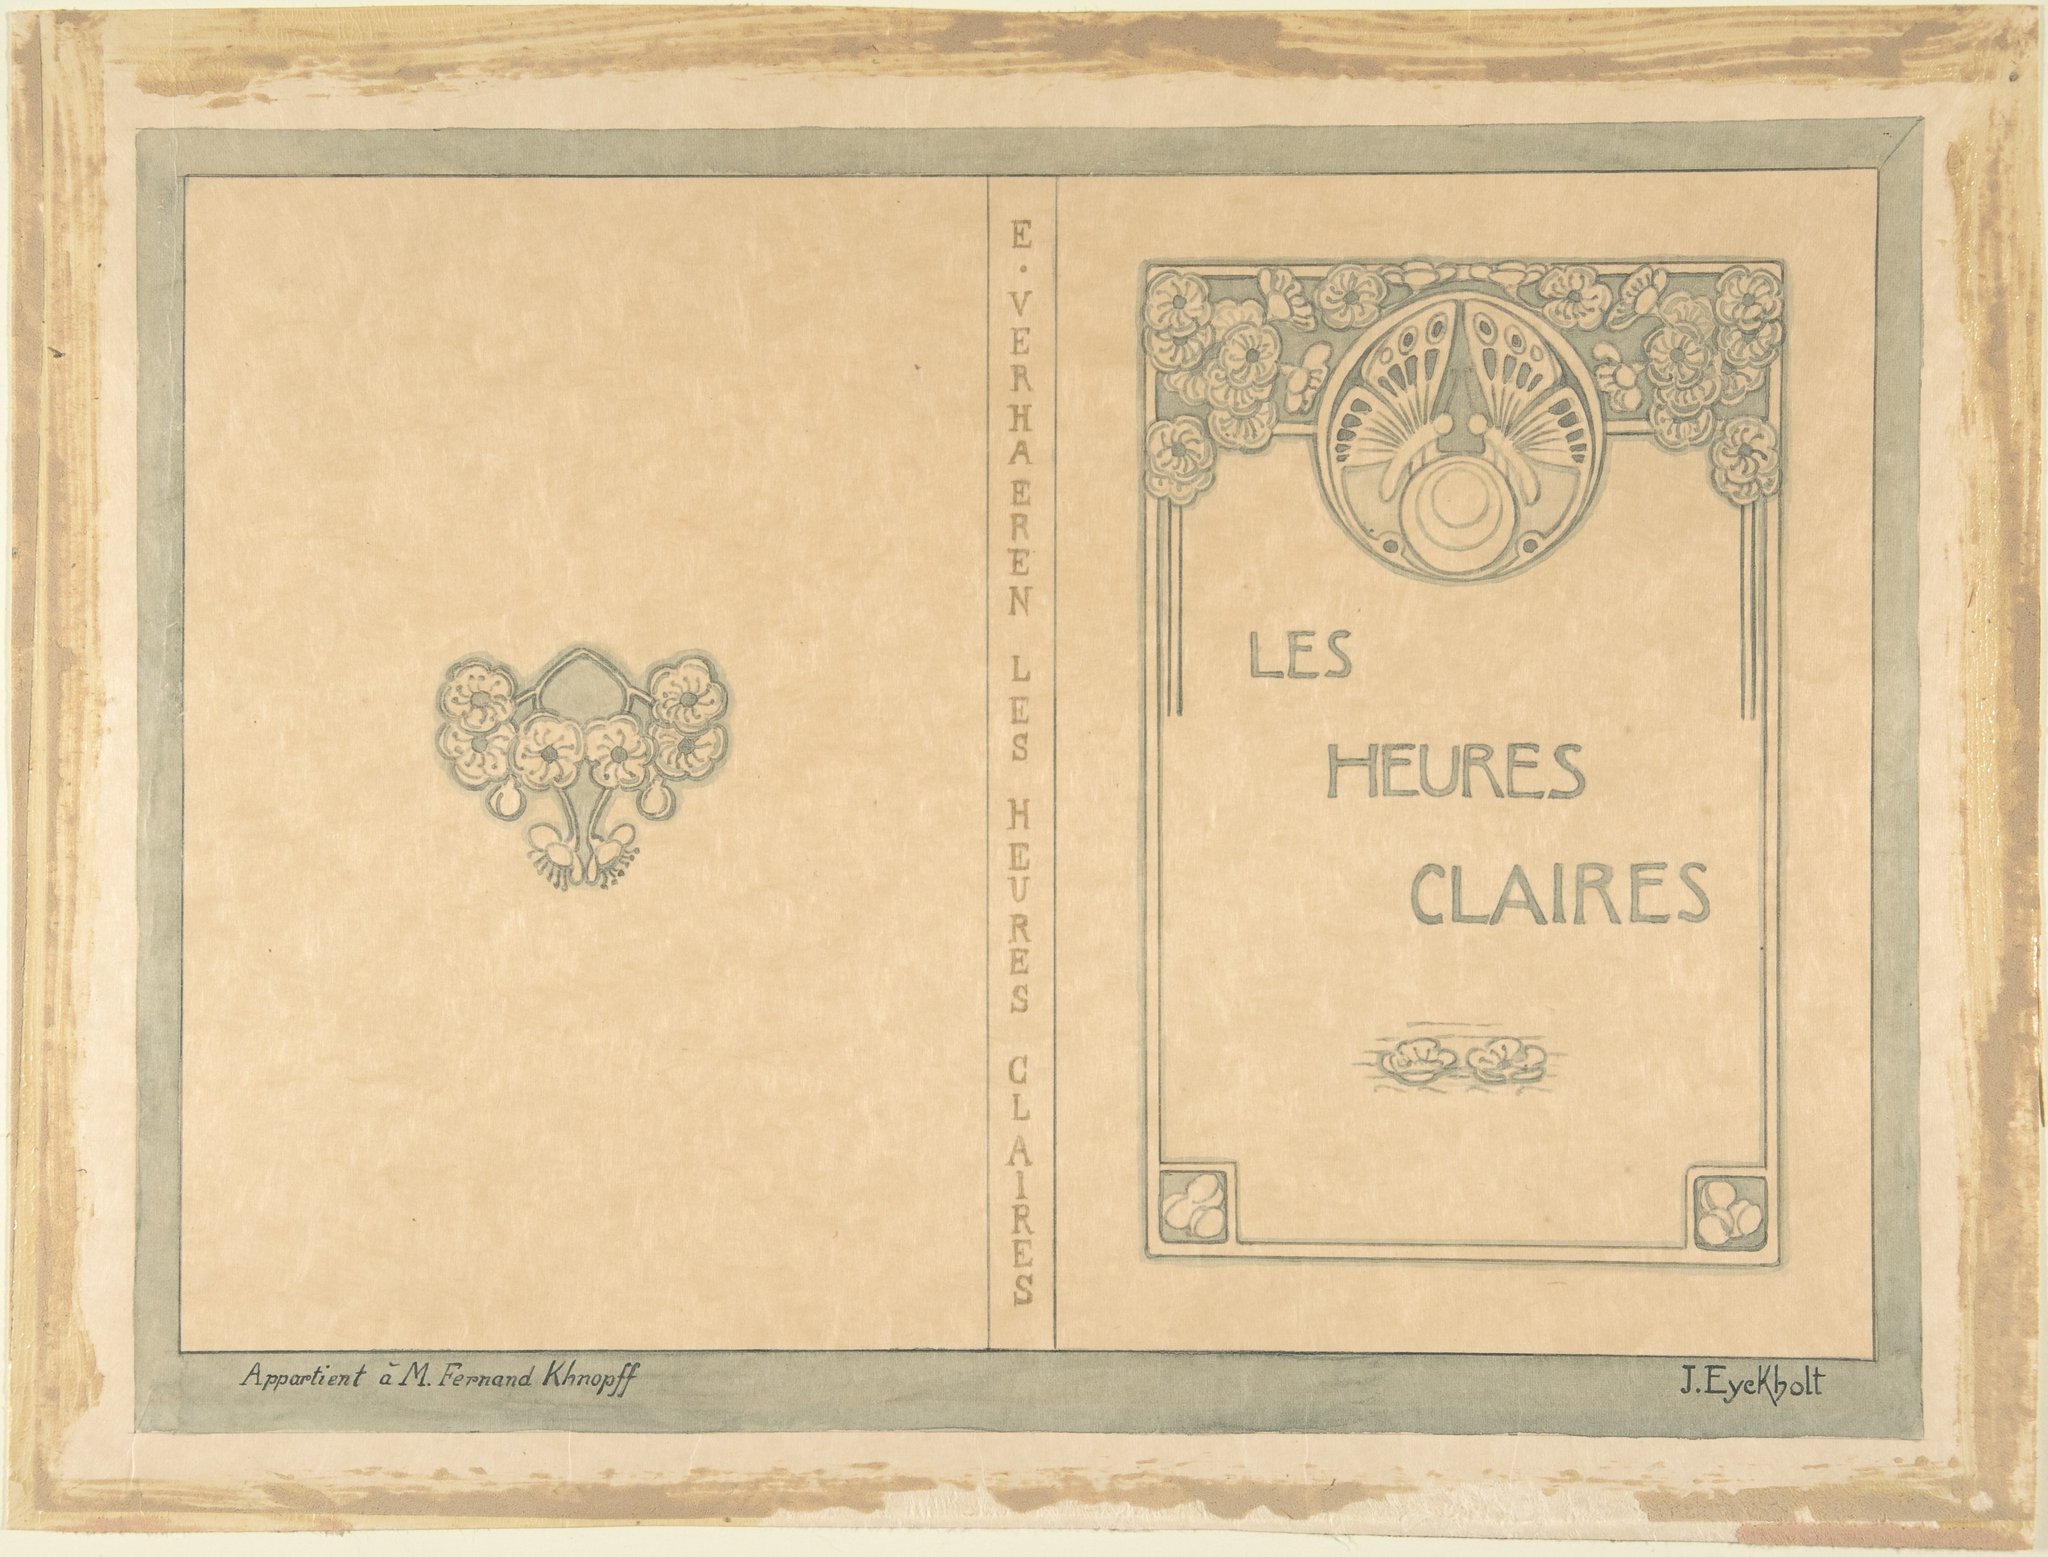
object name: drawing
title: Design for "Les Heures Claires" by Emile Verhaeren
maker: julia eyckholt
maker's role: artist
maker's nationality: belgian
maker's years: 1902-1914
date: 1896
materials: gold, graphite, ink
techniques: brush, pen, drawing, wash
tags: flowers